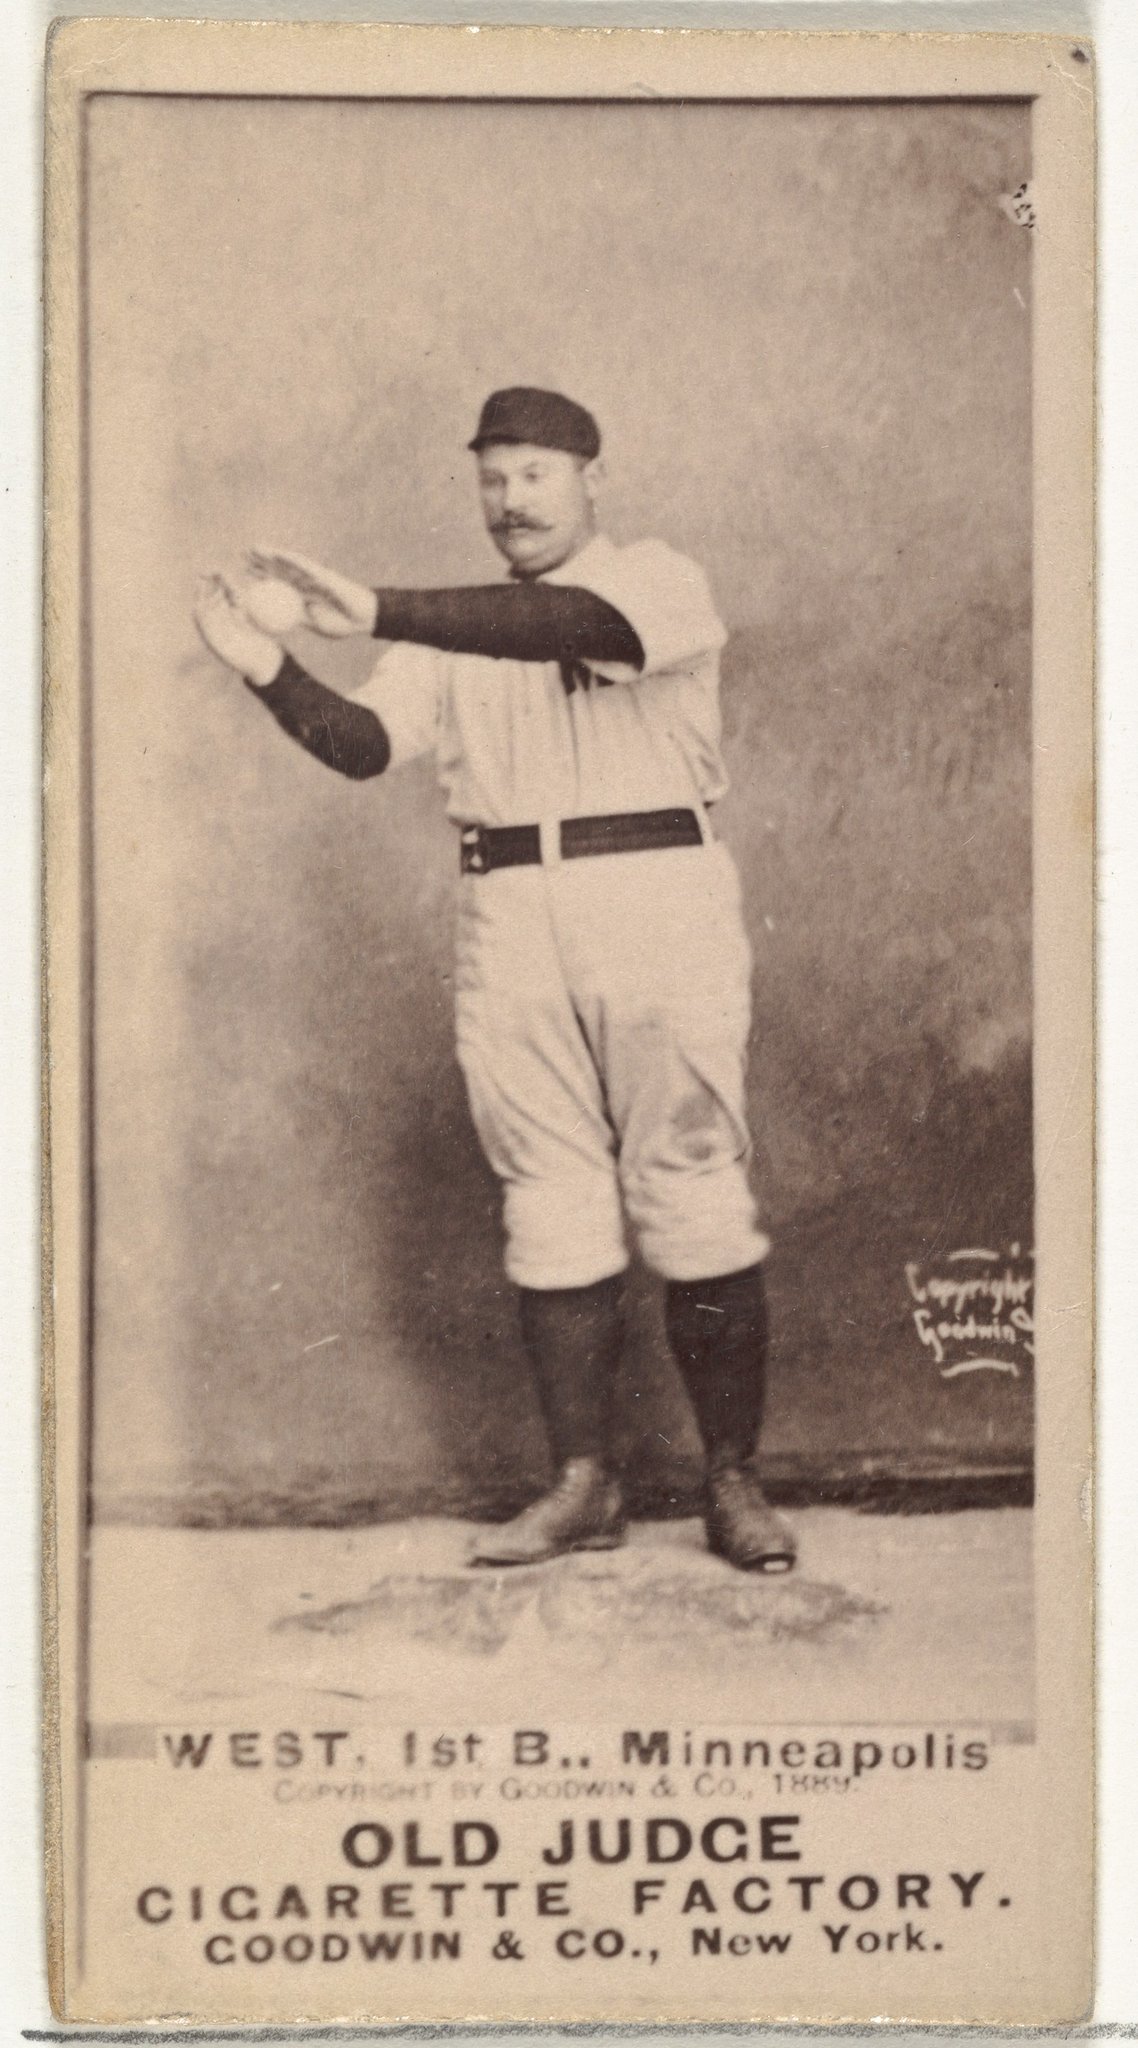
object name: baseball card, photograph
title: Milton Douglas "Buck" West, 1st Base, Minneapolis, from the Old Judge series (N172) for Old Judge Cigarettes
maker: goodwin & company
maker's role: publisher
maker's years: 1850-1950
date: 1889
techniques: albumen silver print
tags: men,portraits,baseball,athletes